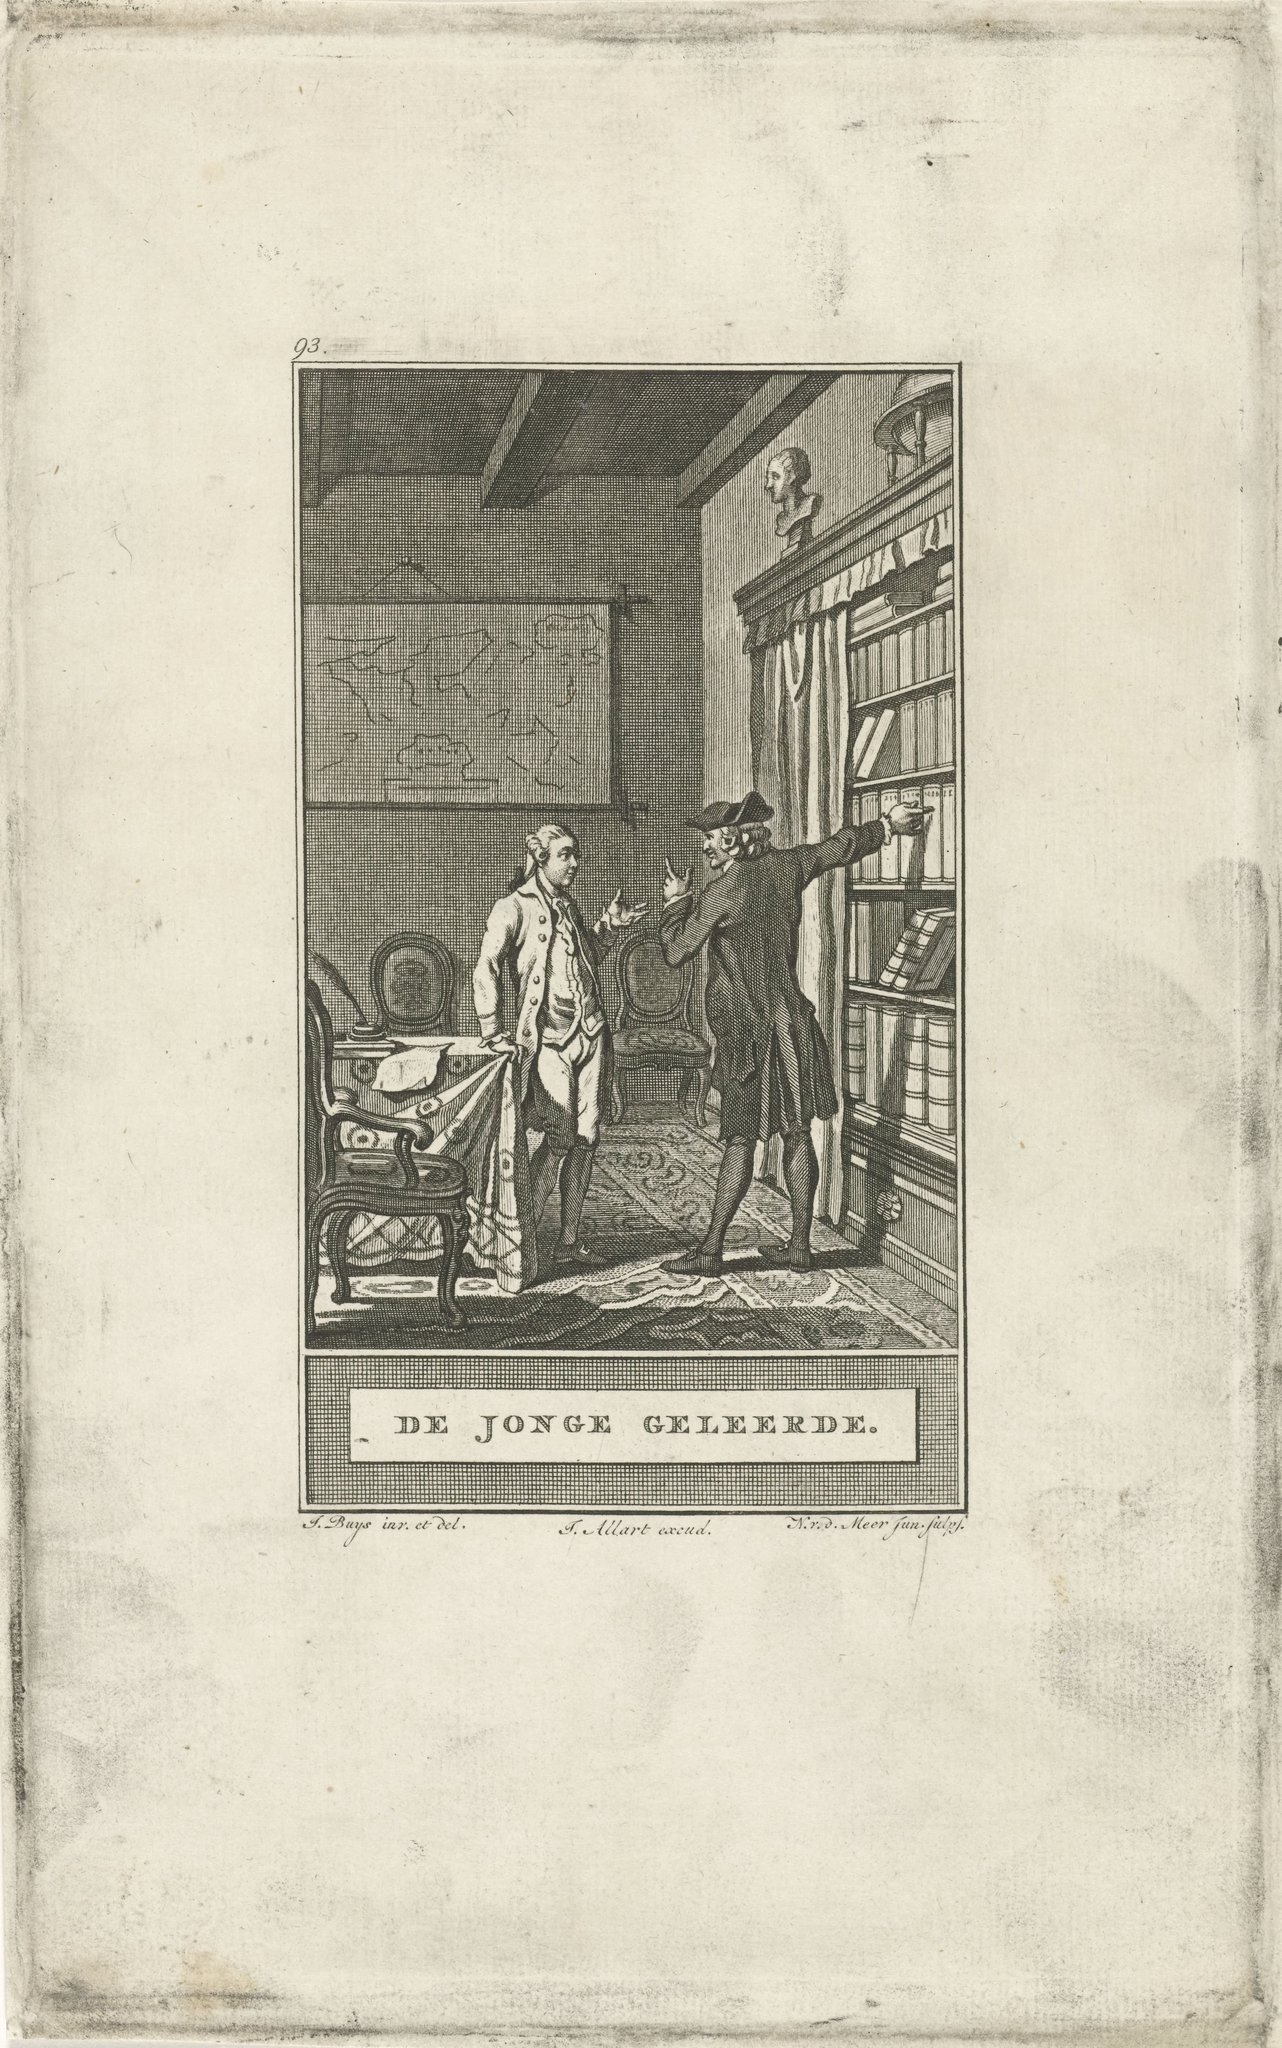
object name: print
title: Gesprek van de jonge geleerde met een oude man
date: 1778-1785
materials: paper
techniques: etching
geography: amsterdam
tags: scholar in his study, maps, atlases, study; 'studiolo'; library, young versus old age; young and old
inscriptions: collector's mark: Lugt 2228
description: Prent bij: Gellert, Christian Fürchtegott. Fabelen en vertelsels. 3 dln. Amsterdam: Pieter Meyer, 1772-1774. De prenten bij deze publicatie werden later uitgegeven. De exemplaren uitgegeven door de weduwe Jacobus Loveringh & Johannes Allart tussen 1777 en 1778, de exemplaren uitgegeven door alleen Johannes Allart tussen 1778 en 1785.